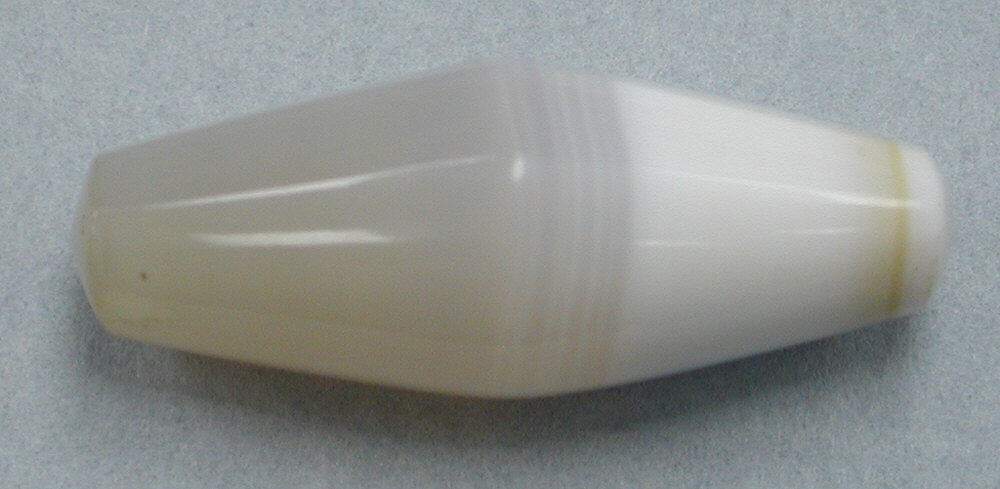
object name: ritual stone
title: Polishing Stone (pulidor)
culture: mexican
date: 1501-1600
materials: stone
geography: mexico